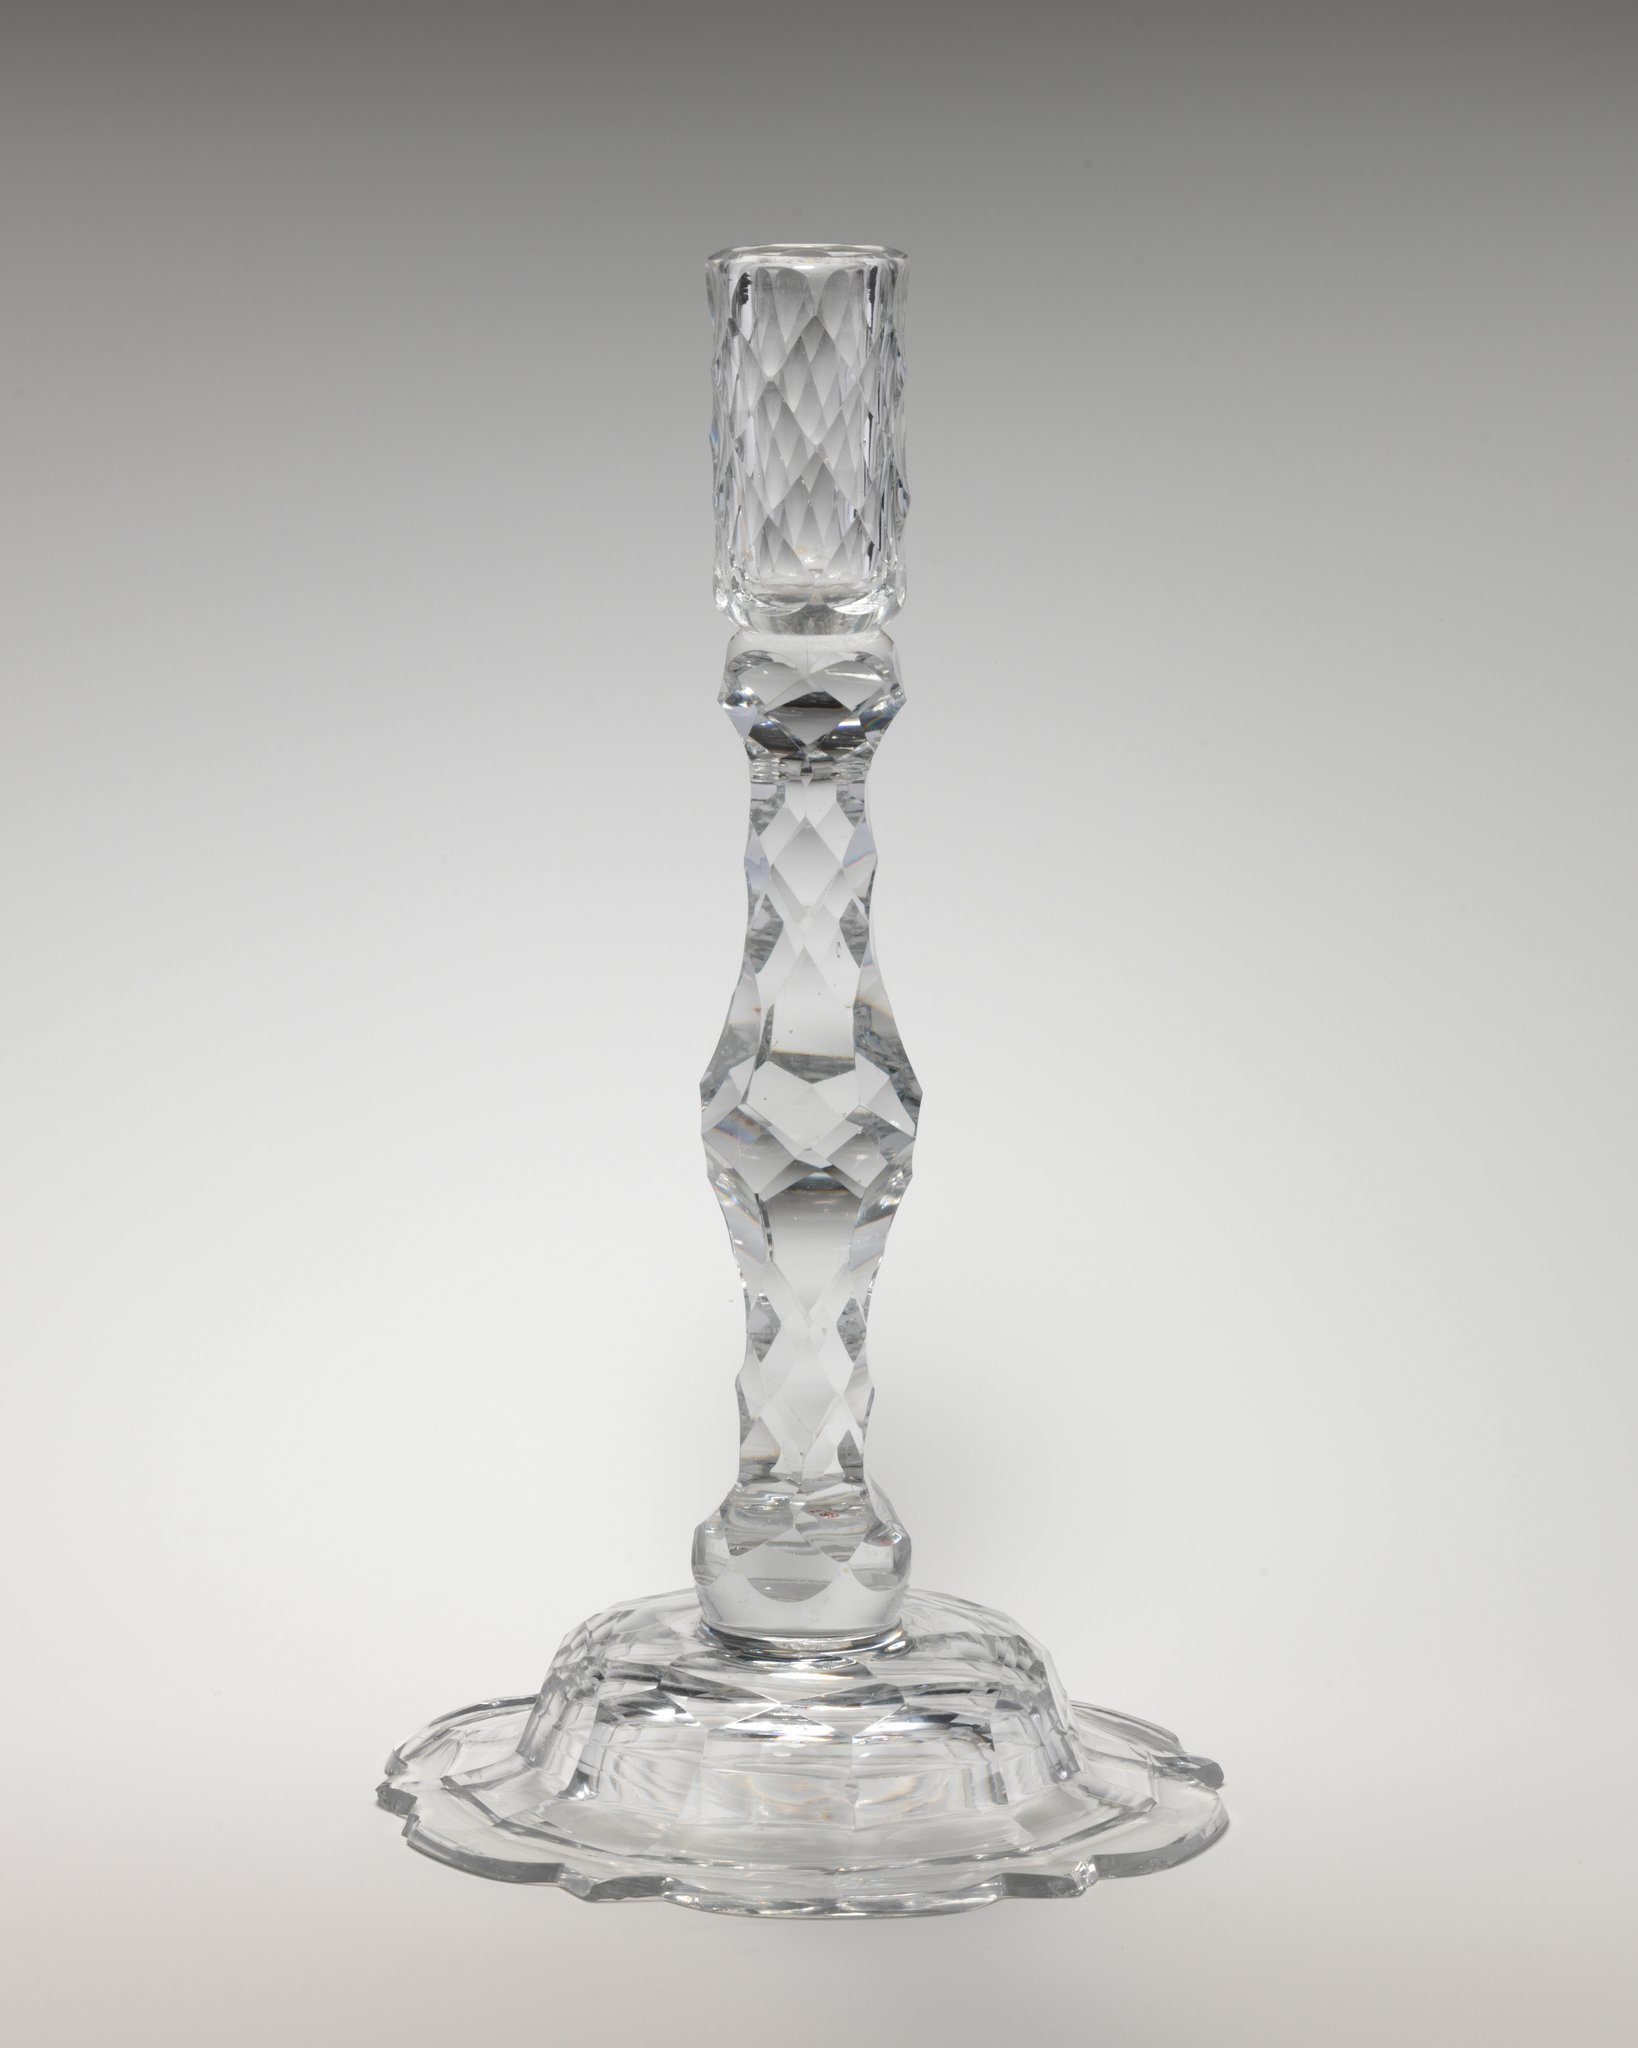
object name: candlestick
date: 1790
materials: glass